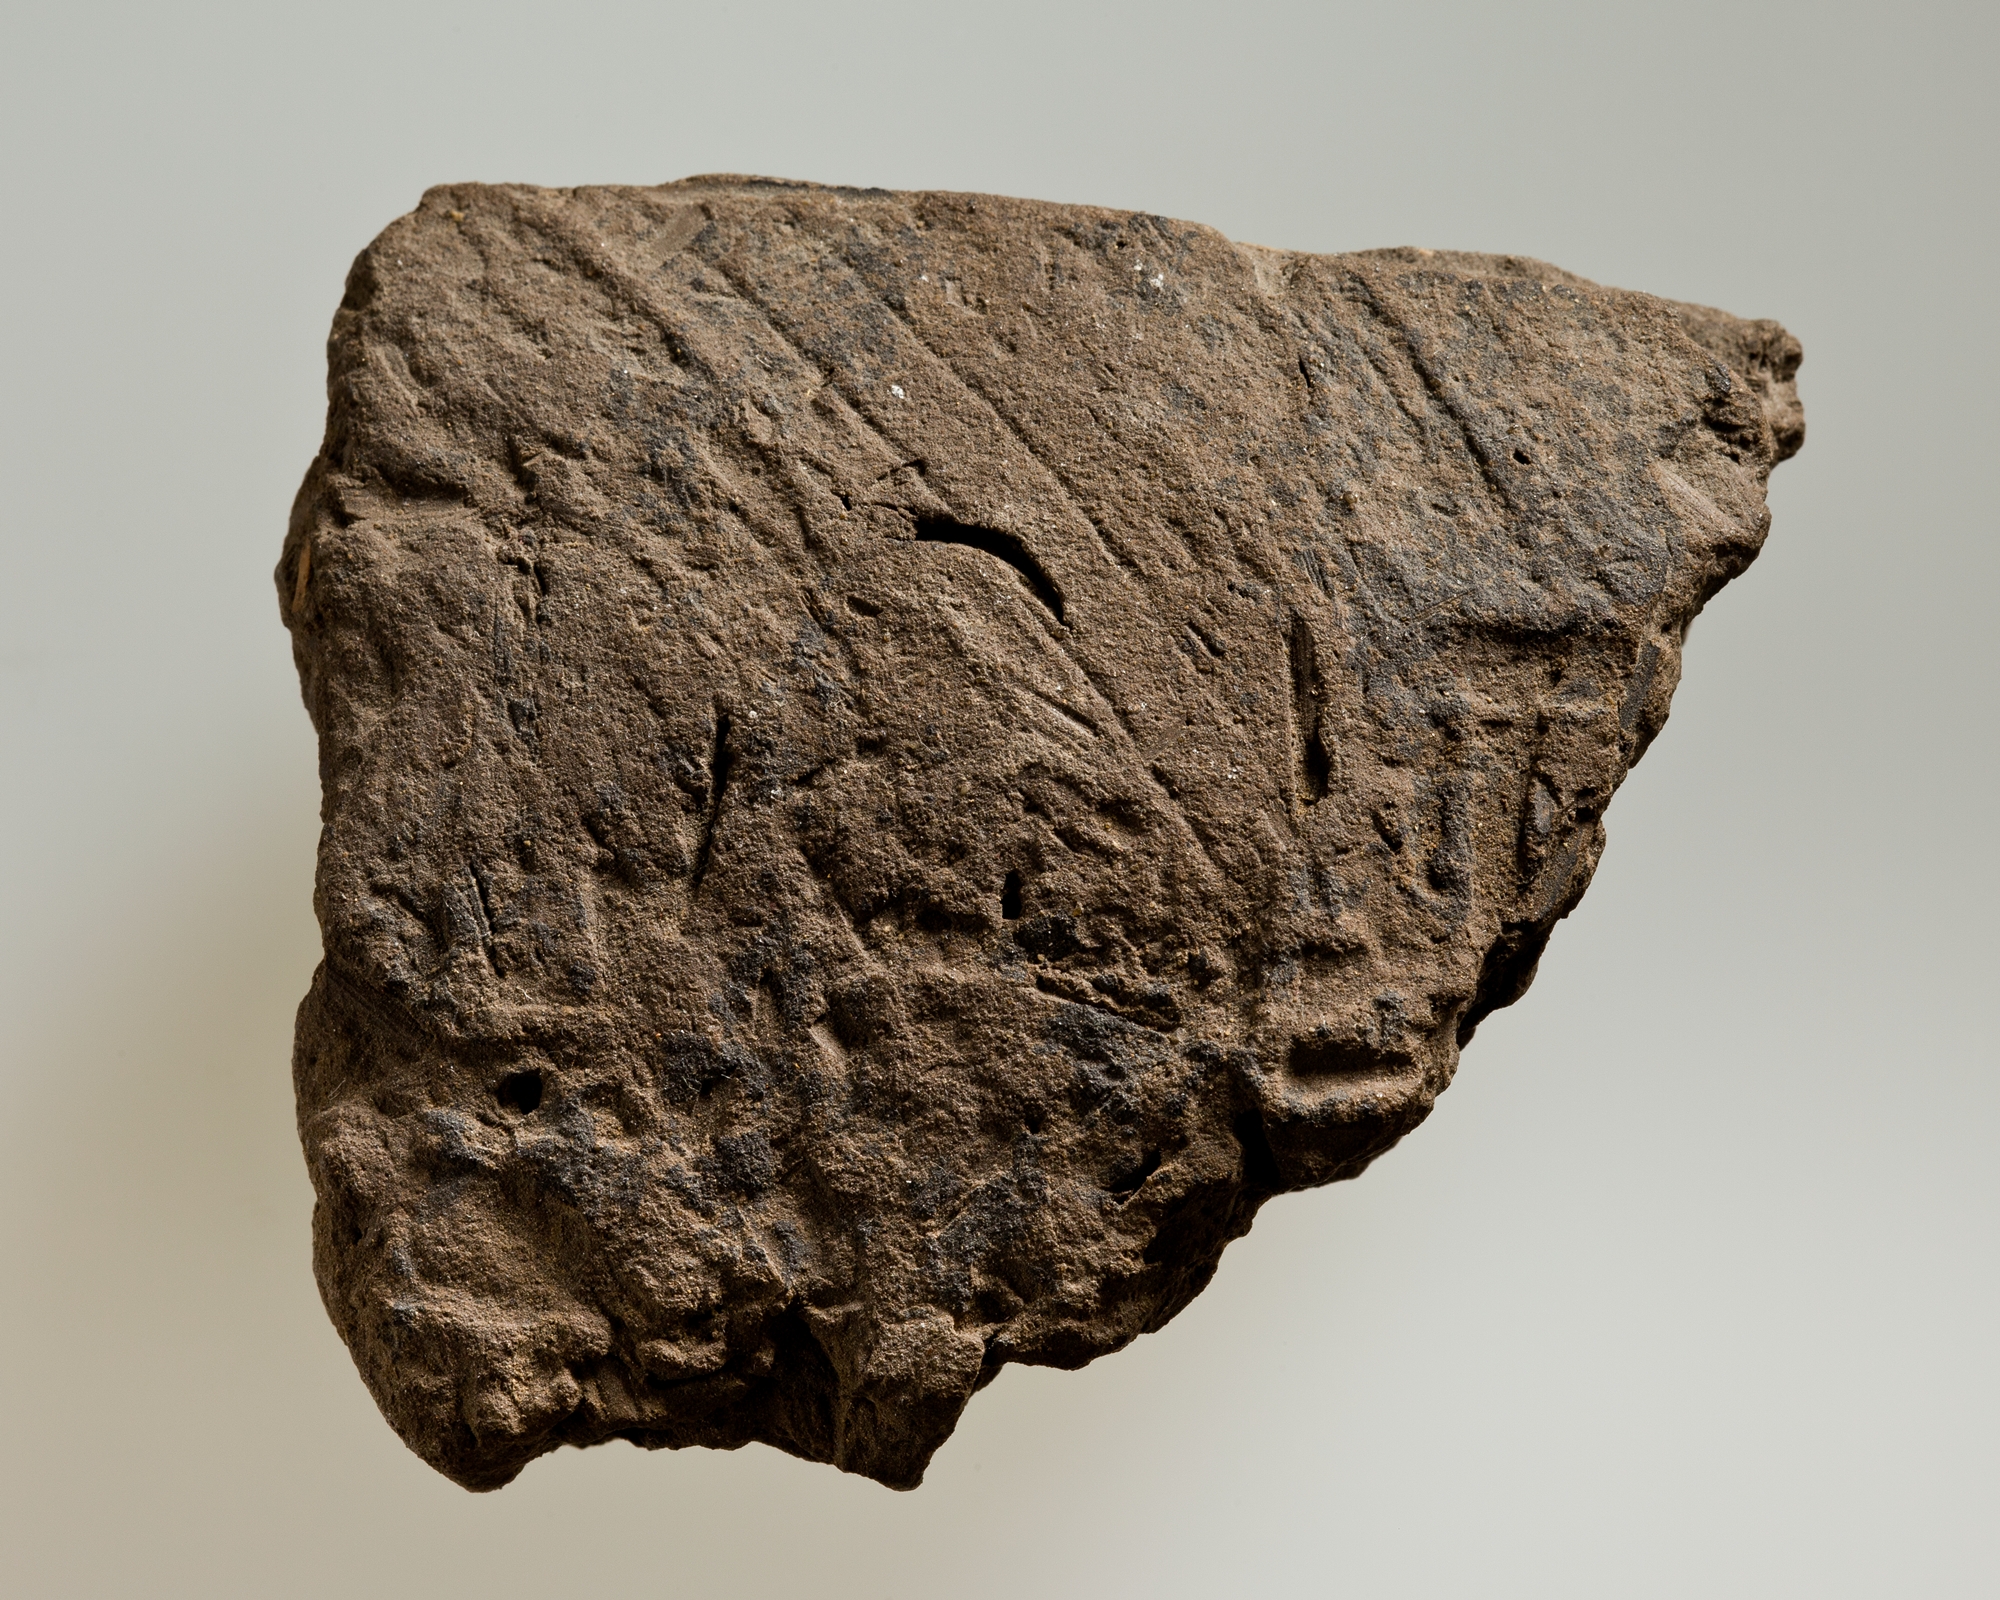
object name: sealing, jar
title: Mud jar sealing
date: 3200-2650 BCE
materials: clay, mud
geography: egypt